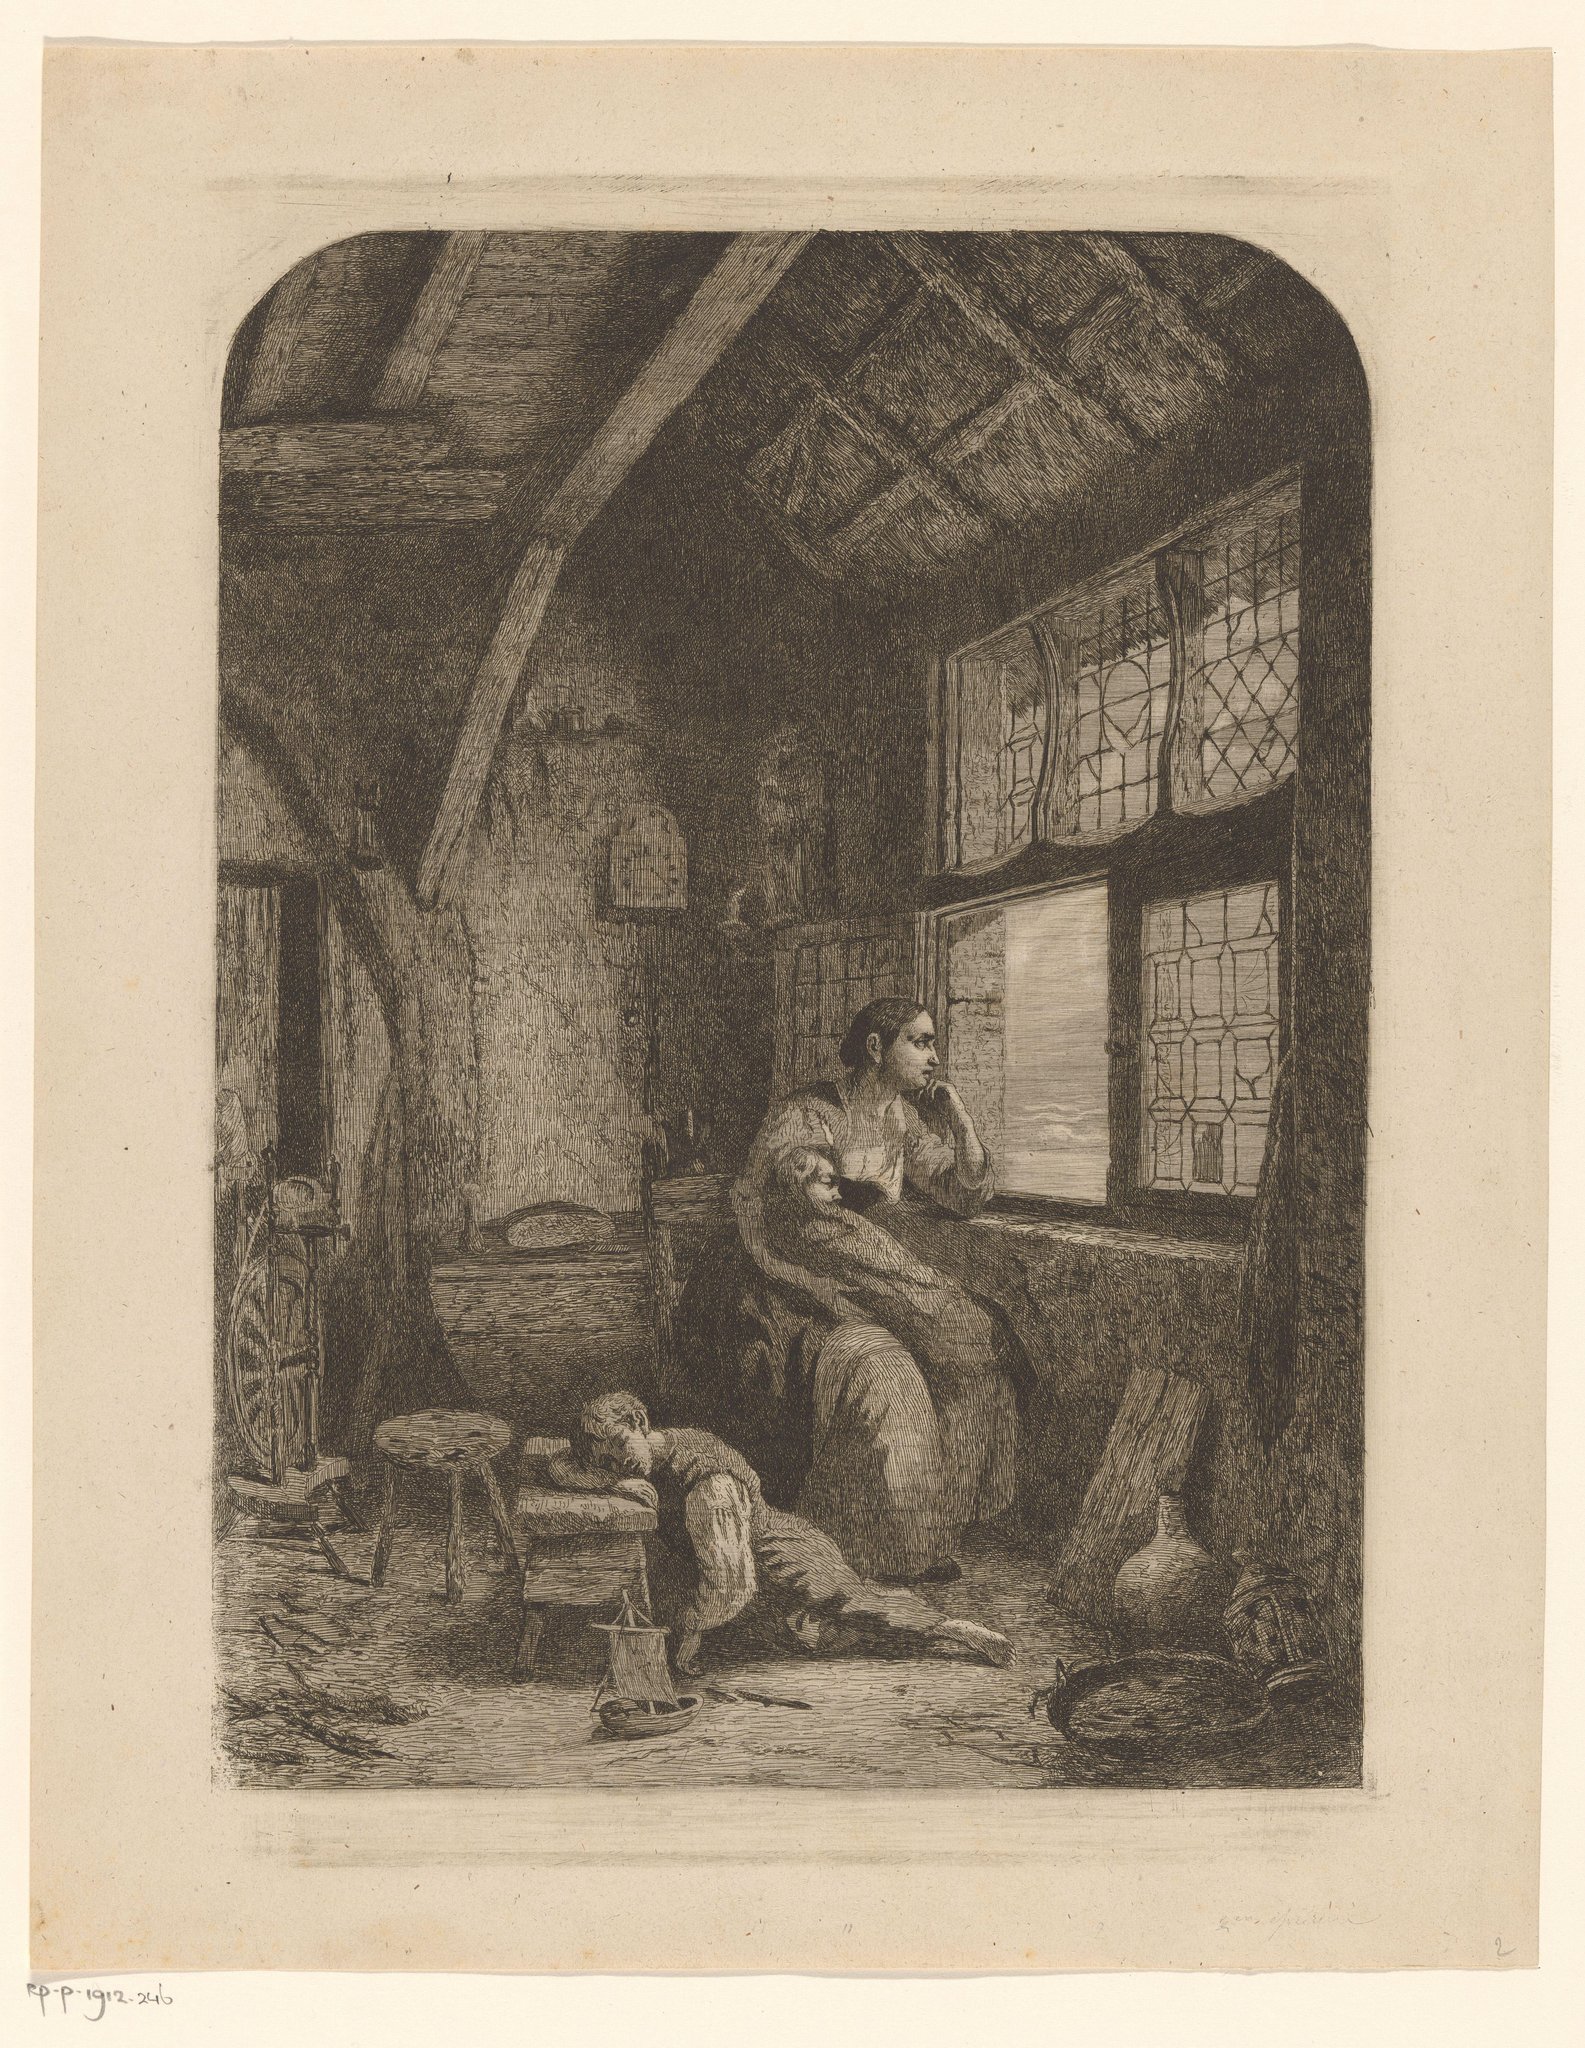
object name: print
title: Vrouw met twee slapende kinderen wachtend bij een open raam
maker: willem linnig (i)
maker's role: print maker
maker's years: 1819-1885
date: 1856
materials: paper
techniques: etching, intaglio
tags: mother and child(ren), woman and child(ren) (family group)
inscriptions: collector's mark: Lugt 2228, collector's mark: Lugt 1485, annotation: ‘2me état / il existe 2 exemplaires de cet état’